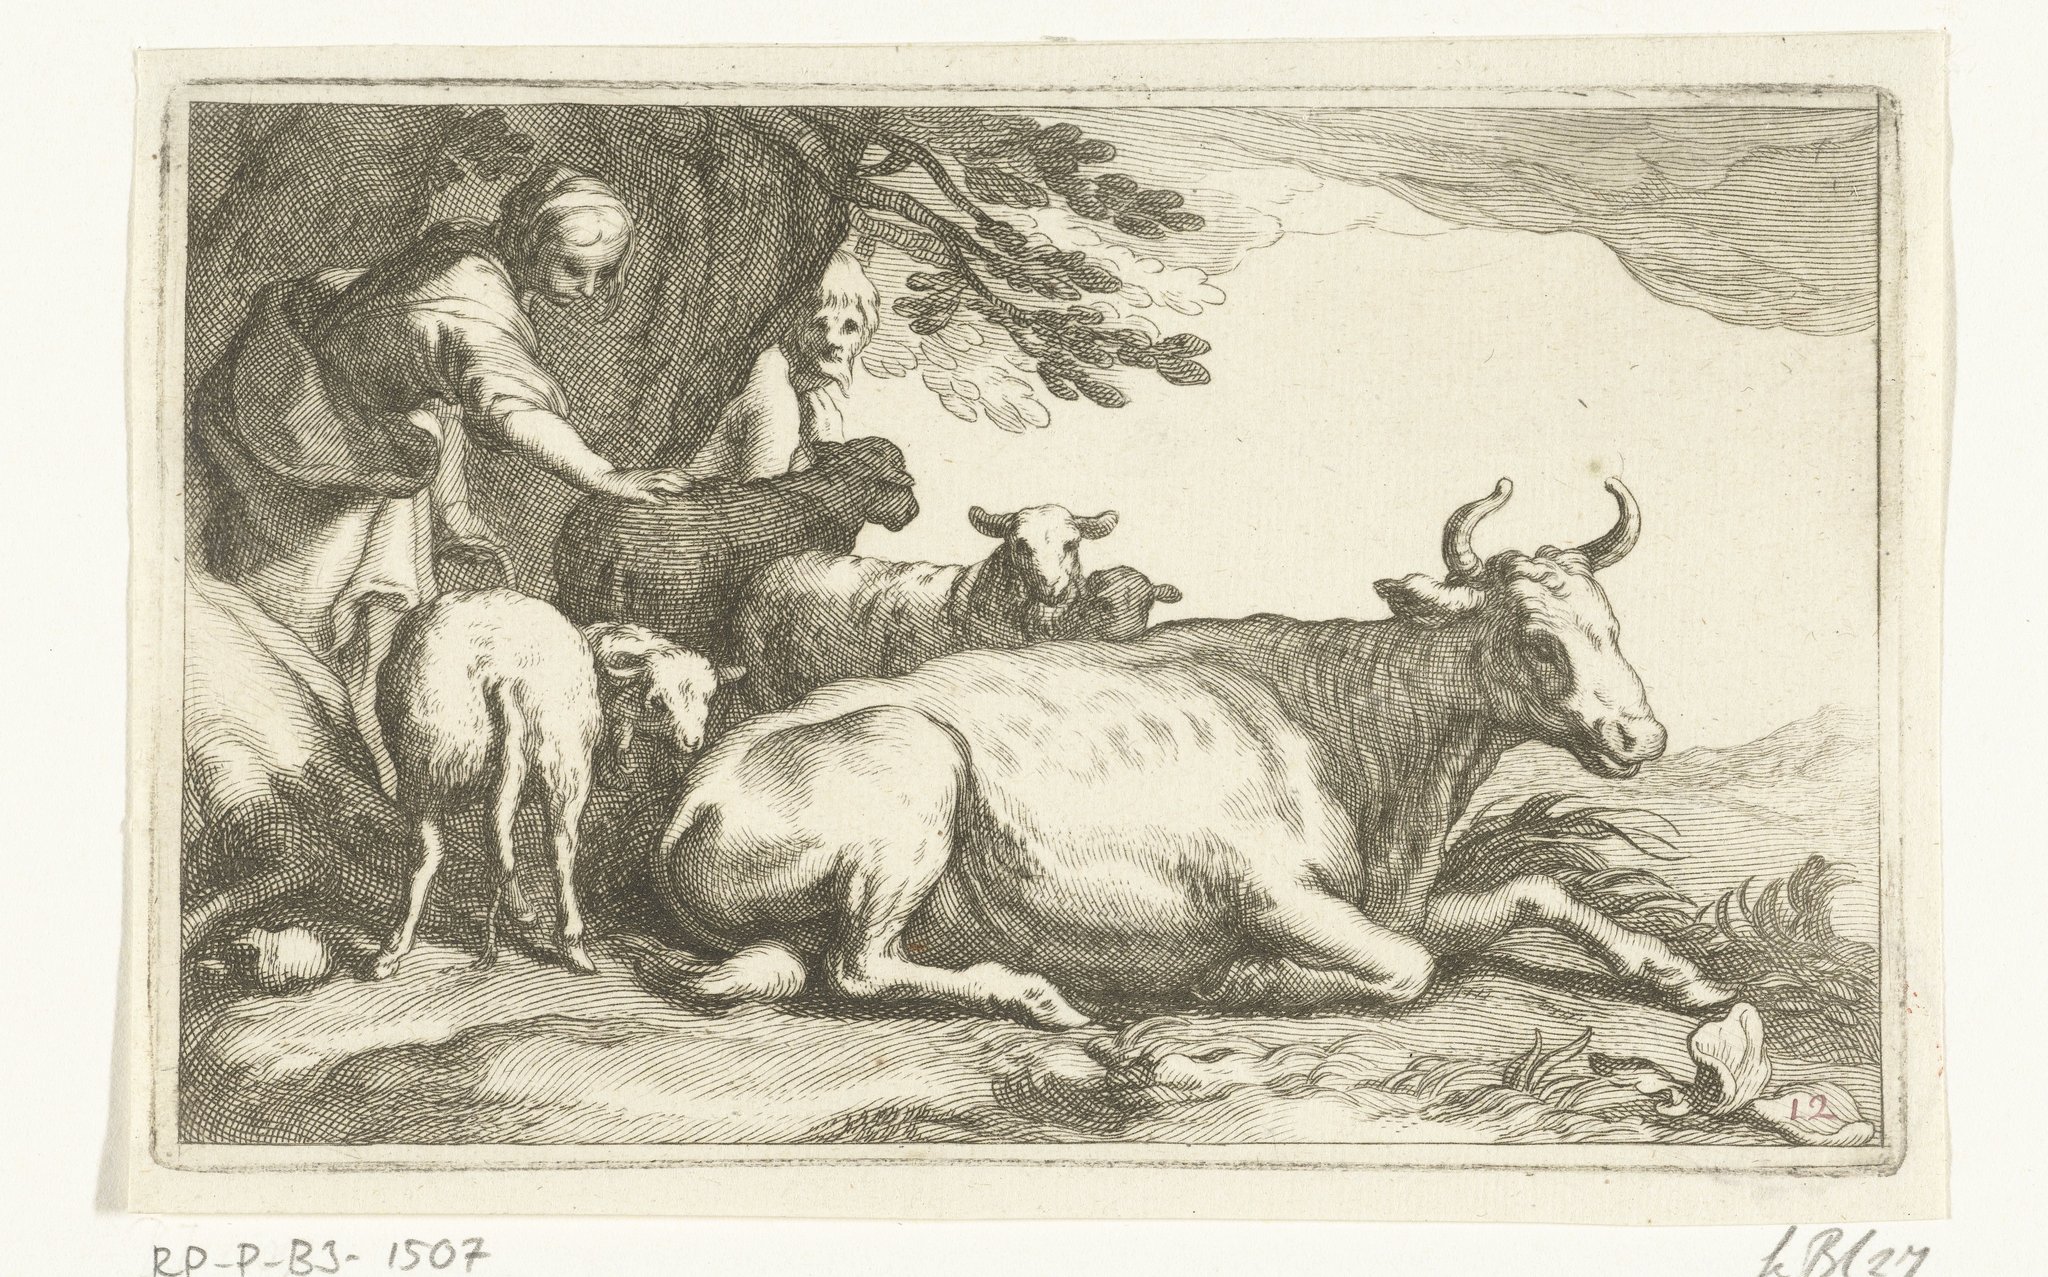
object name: print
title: Dieren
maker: frederick bloemaert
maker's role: print maker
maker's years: 1614-1669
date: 1635-1670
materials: paper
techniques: engraving, etching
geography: utrecht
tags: cow, pastorals, arcadian scenes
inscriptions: collector's mark: Lugt 240, number: ‘12’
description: Een herder en een herderin met een kudde bestaande uit schapen en koeien. Prent uit een serie van 14 prenten met verschillende inheemse dieren.